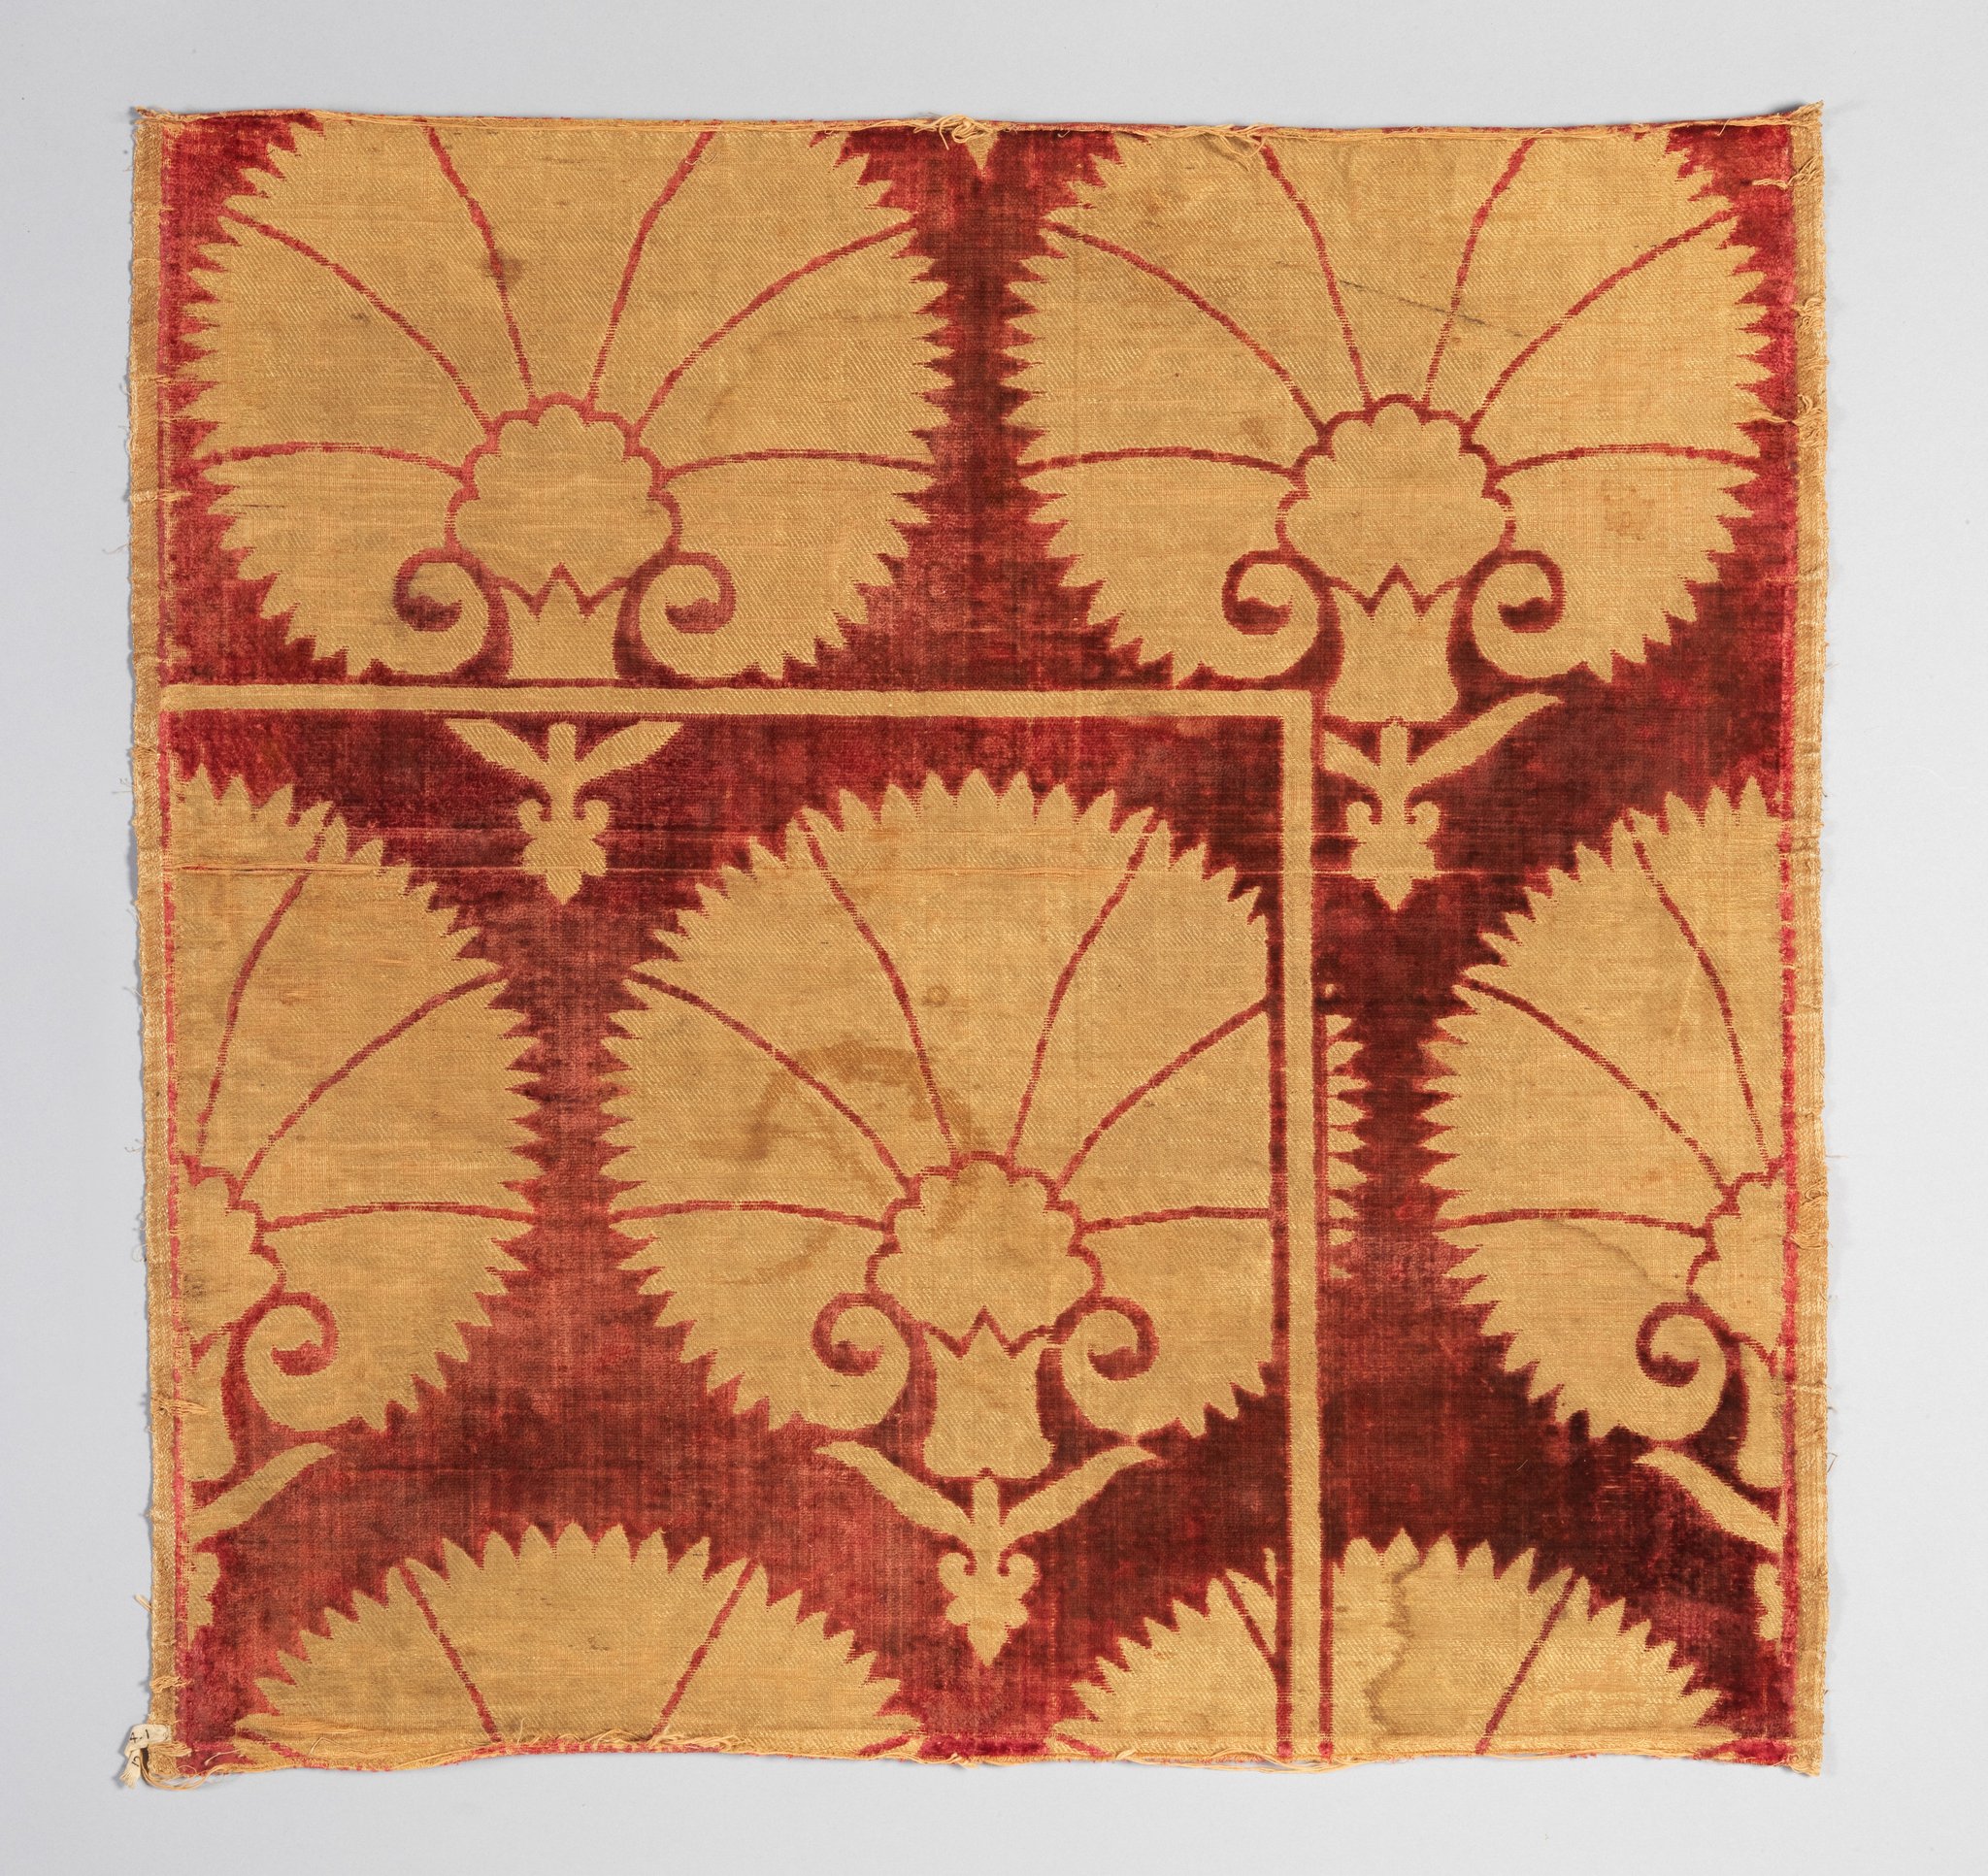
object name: cover fragment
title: Fragment of a Cover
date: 1601-1700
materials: silk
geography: turkey